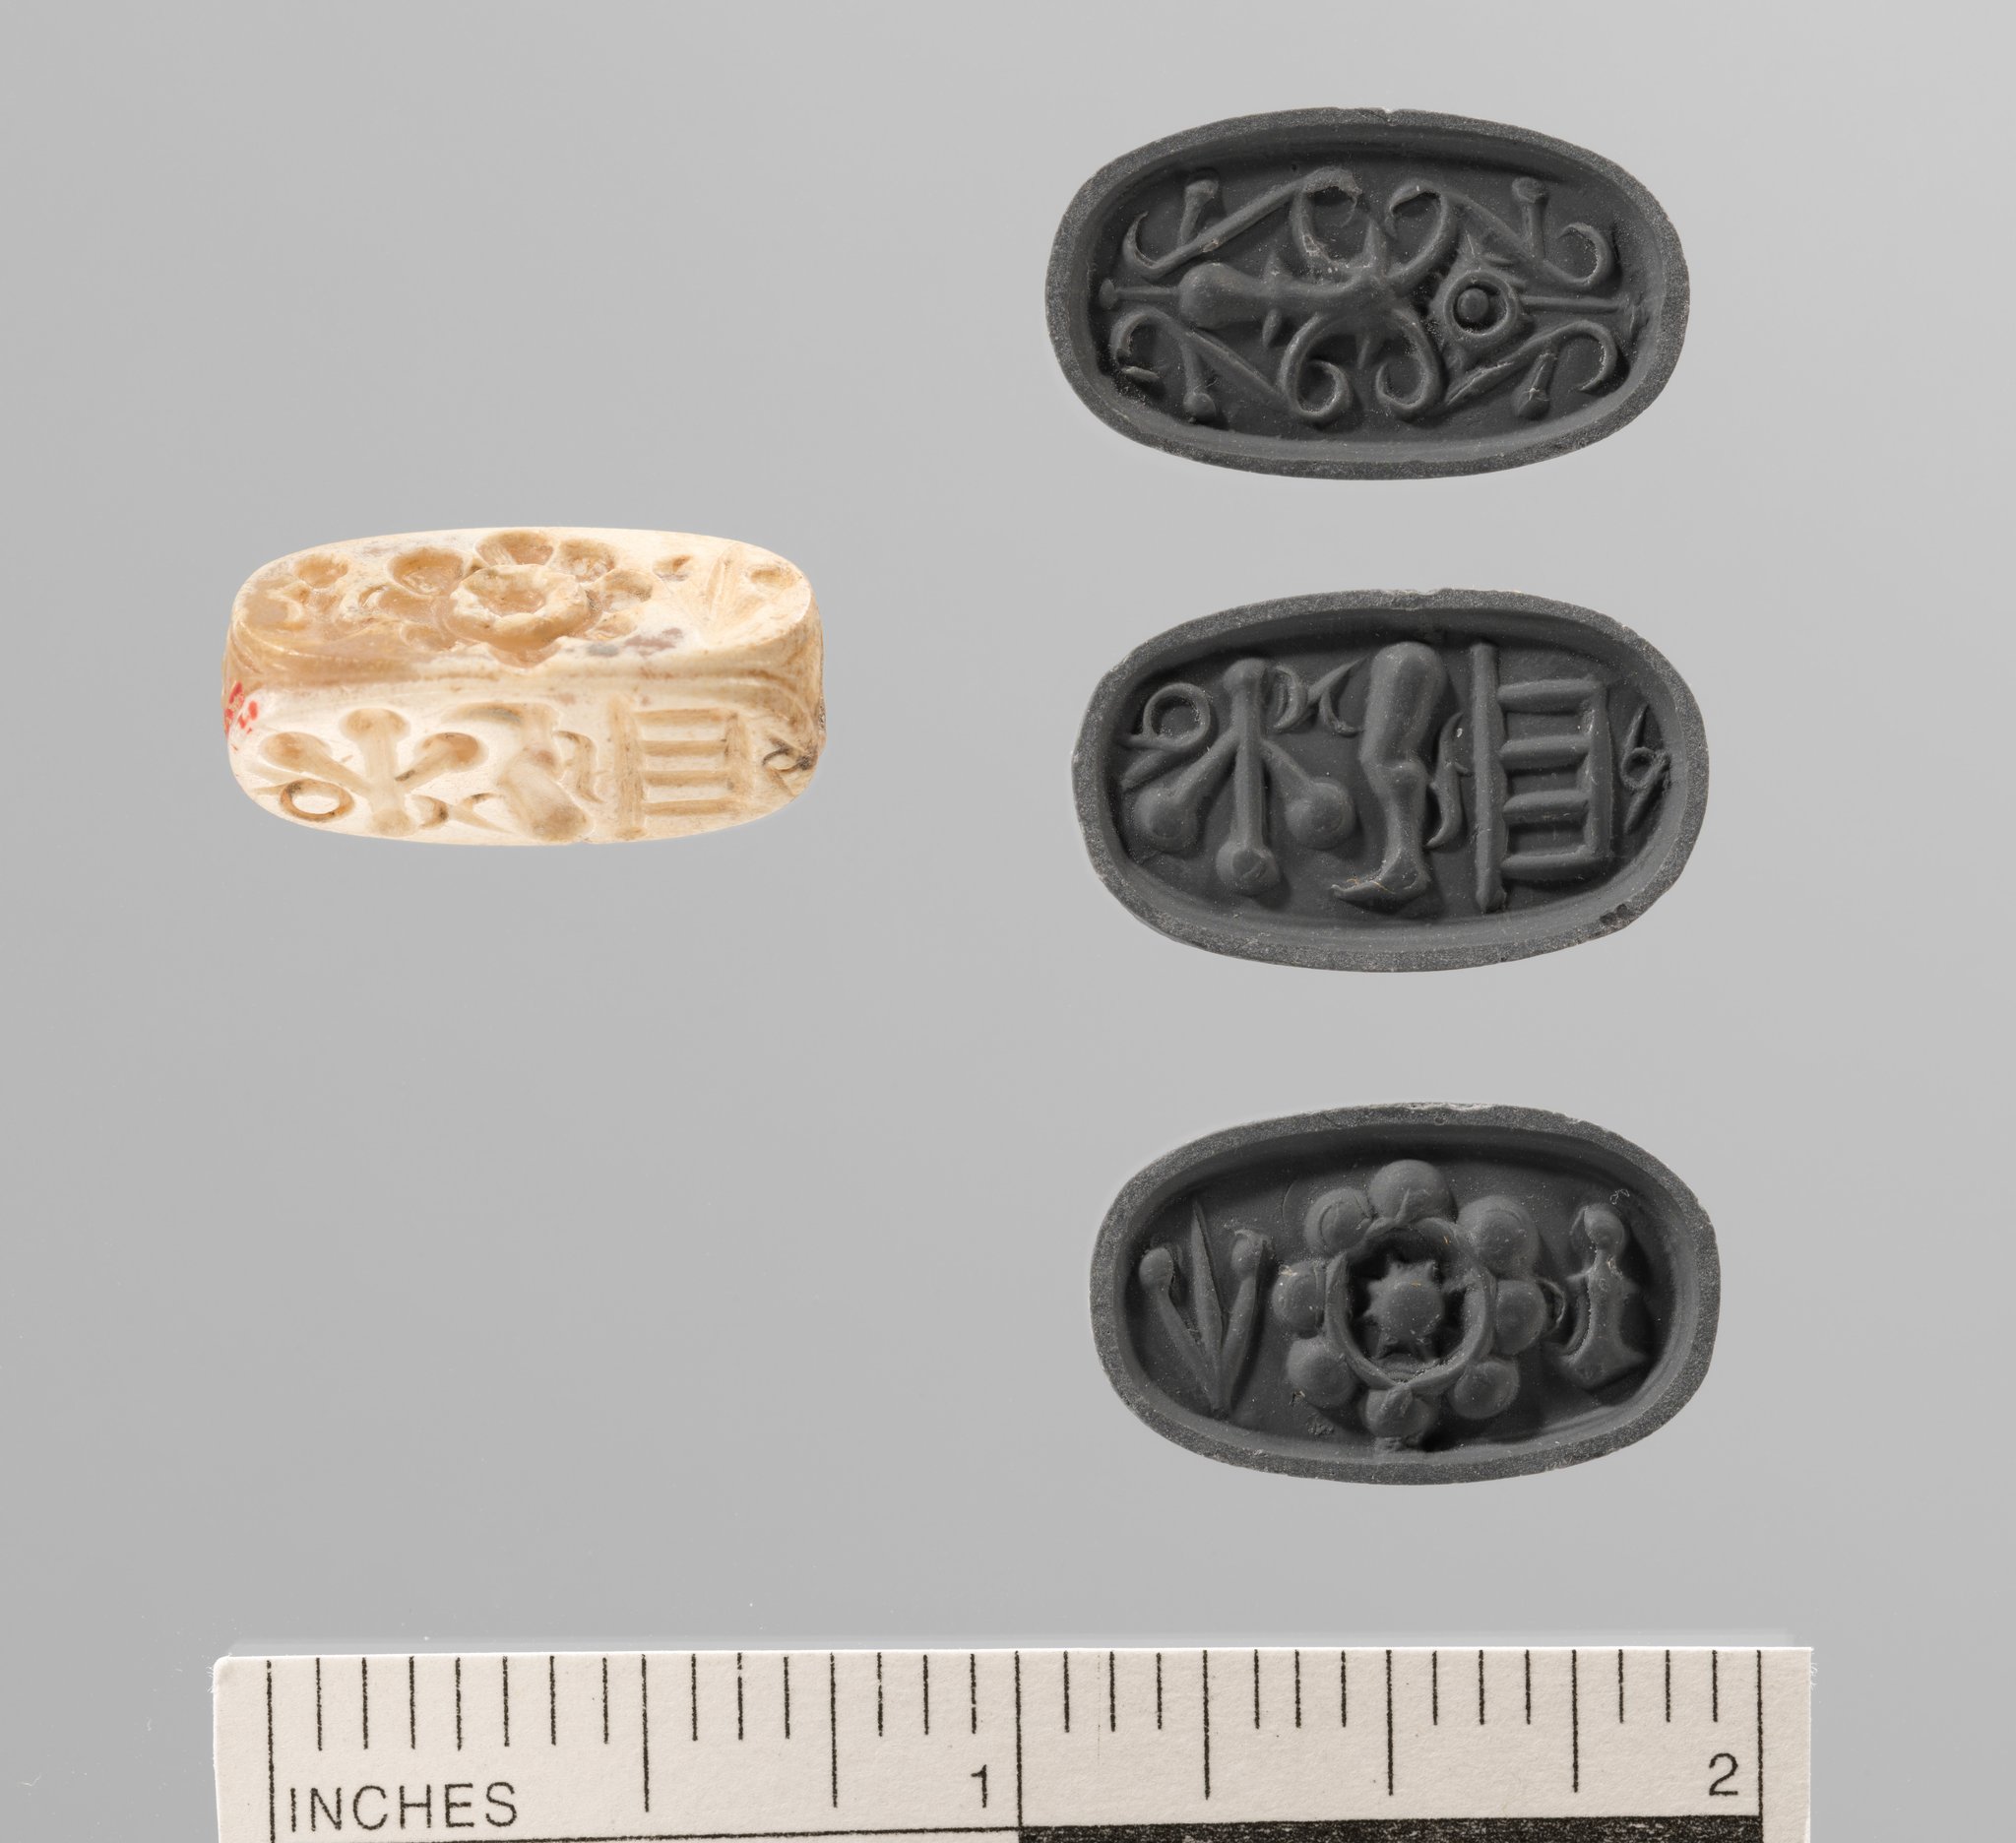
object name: prism, triangular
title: Chalcedony Triangular Prism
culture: minoan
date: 1800-1600 BCE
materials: stone